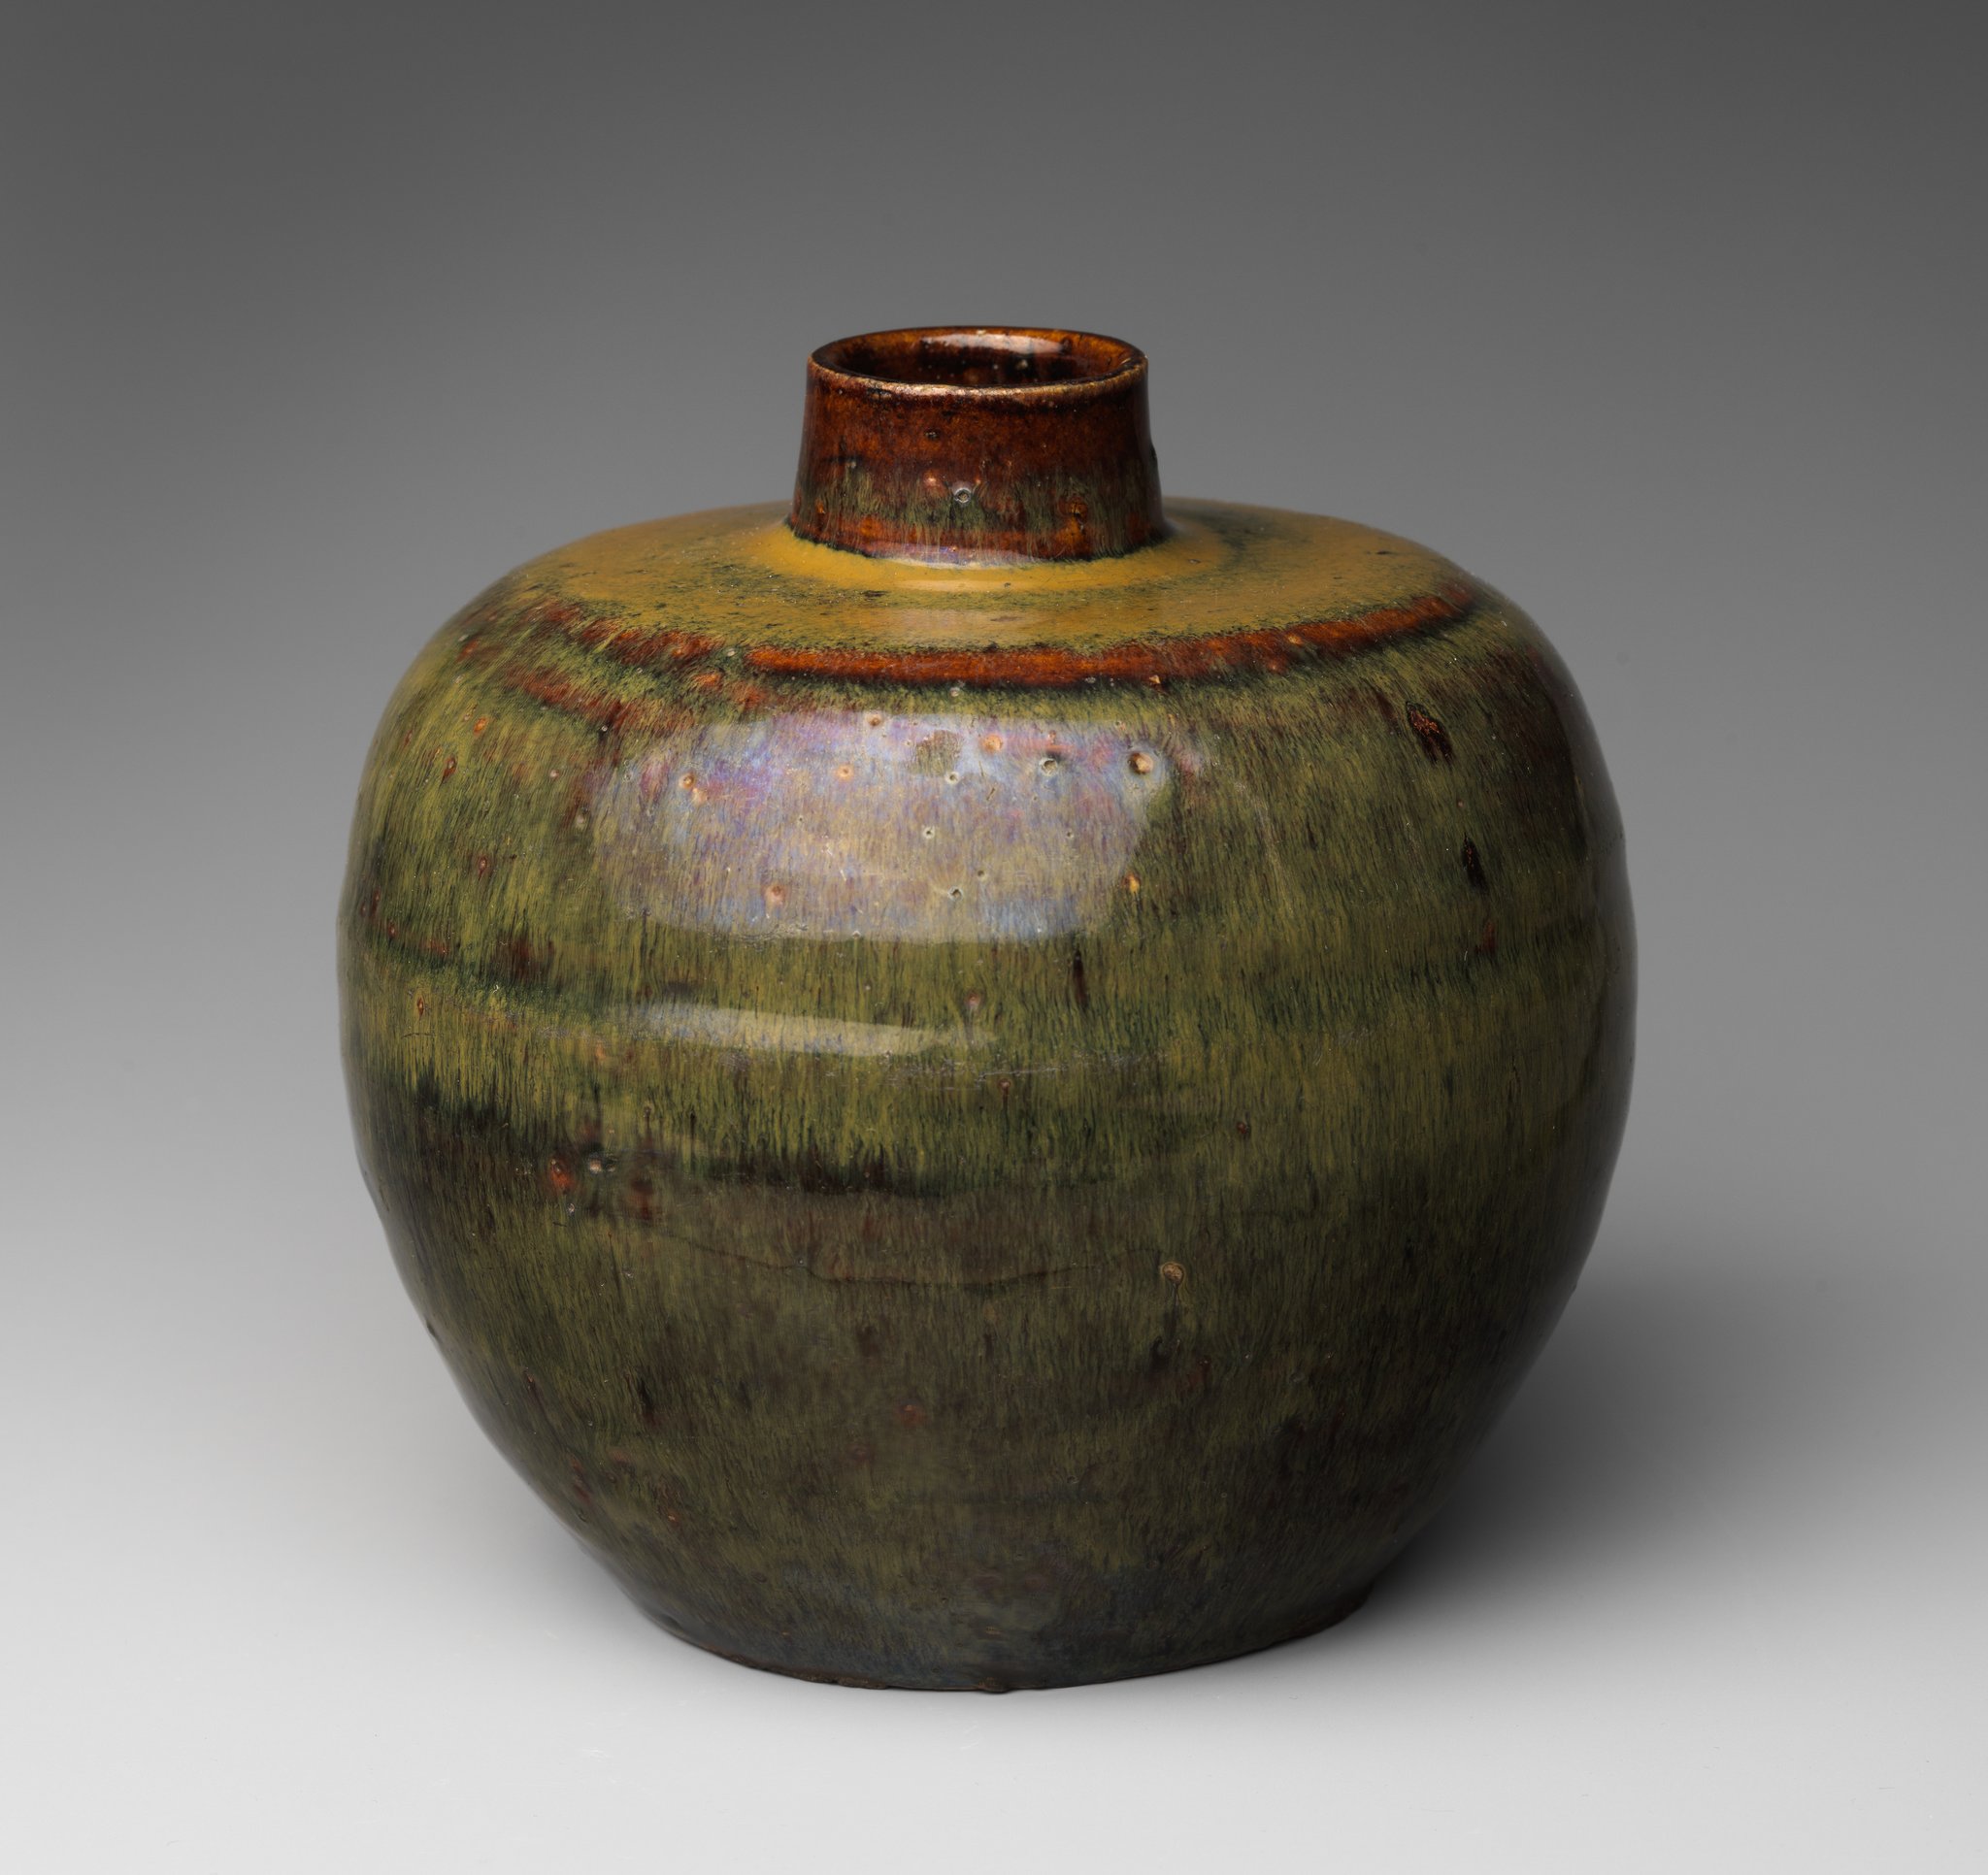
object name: bottle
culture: japanese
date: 1801-1833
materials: glaze, pottery